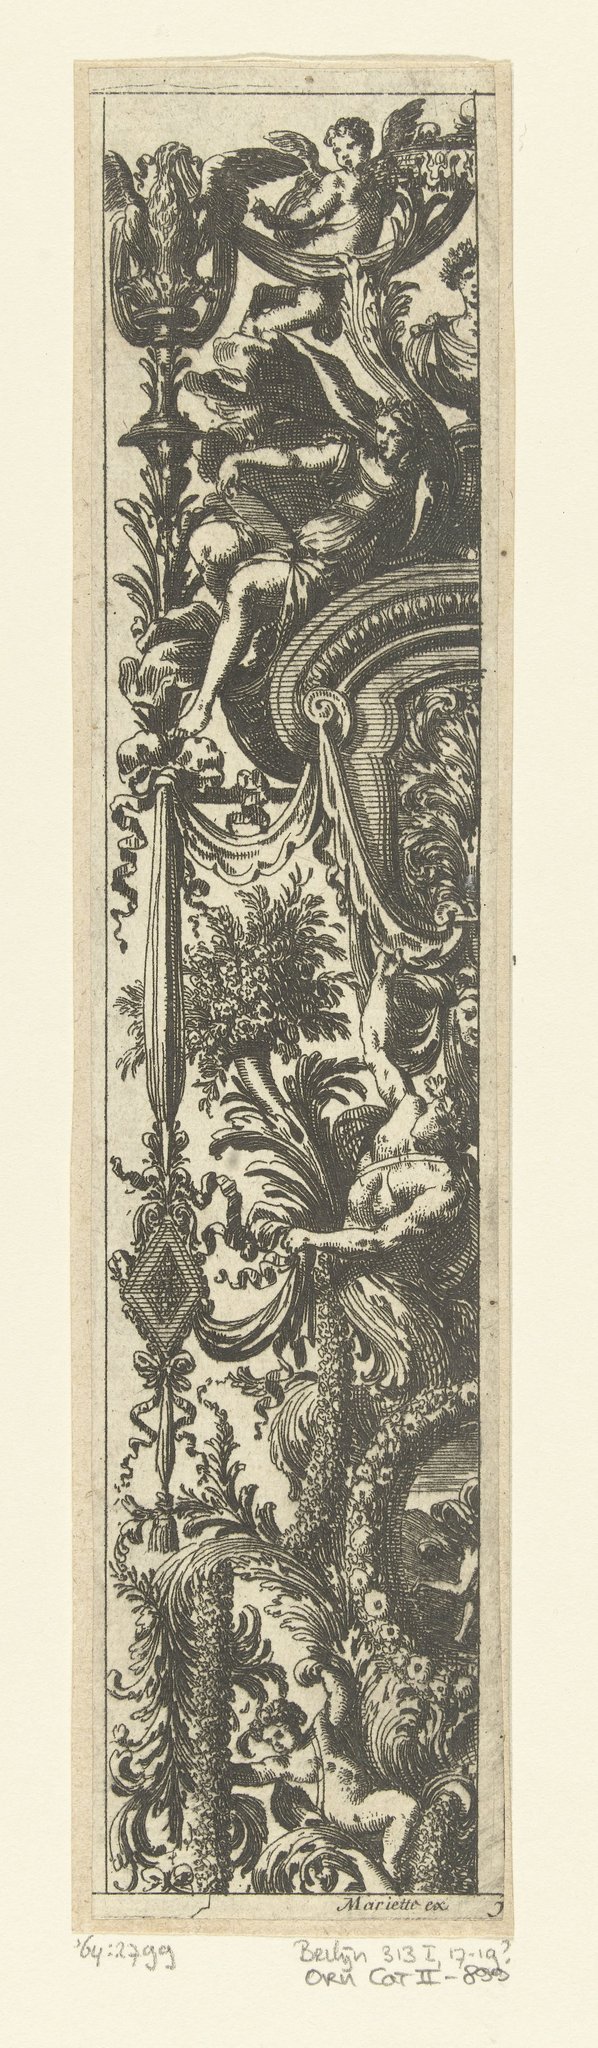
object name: ornament print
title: Paneel met kleine keizersbuste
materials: paper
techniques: etching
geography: france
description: Rechtsboven staat een keizersbuste onder een baldakijn, linksboven zit een adelaar. Blad uit tweede editie.